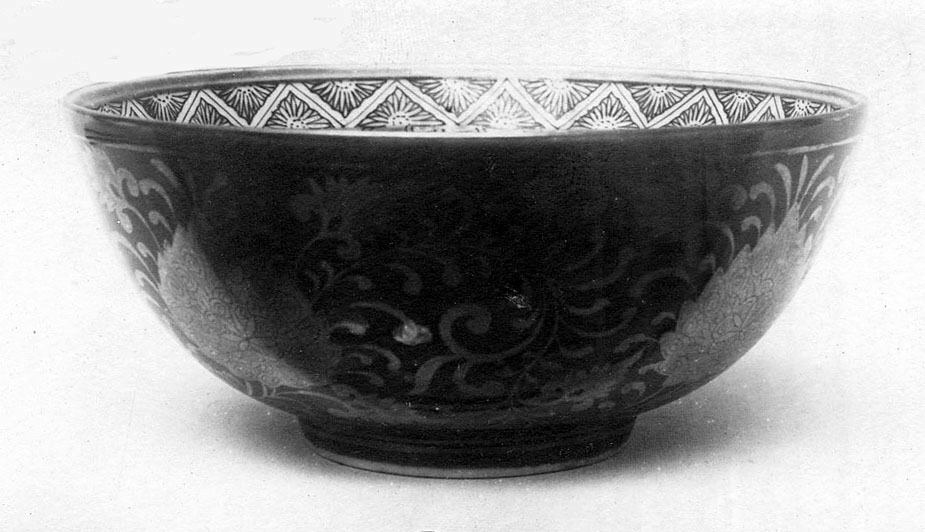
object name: bowl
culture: japanese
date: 1780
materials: enamel, glaze, gold, porcelain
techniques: painting